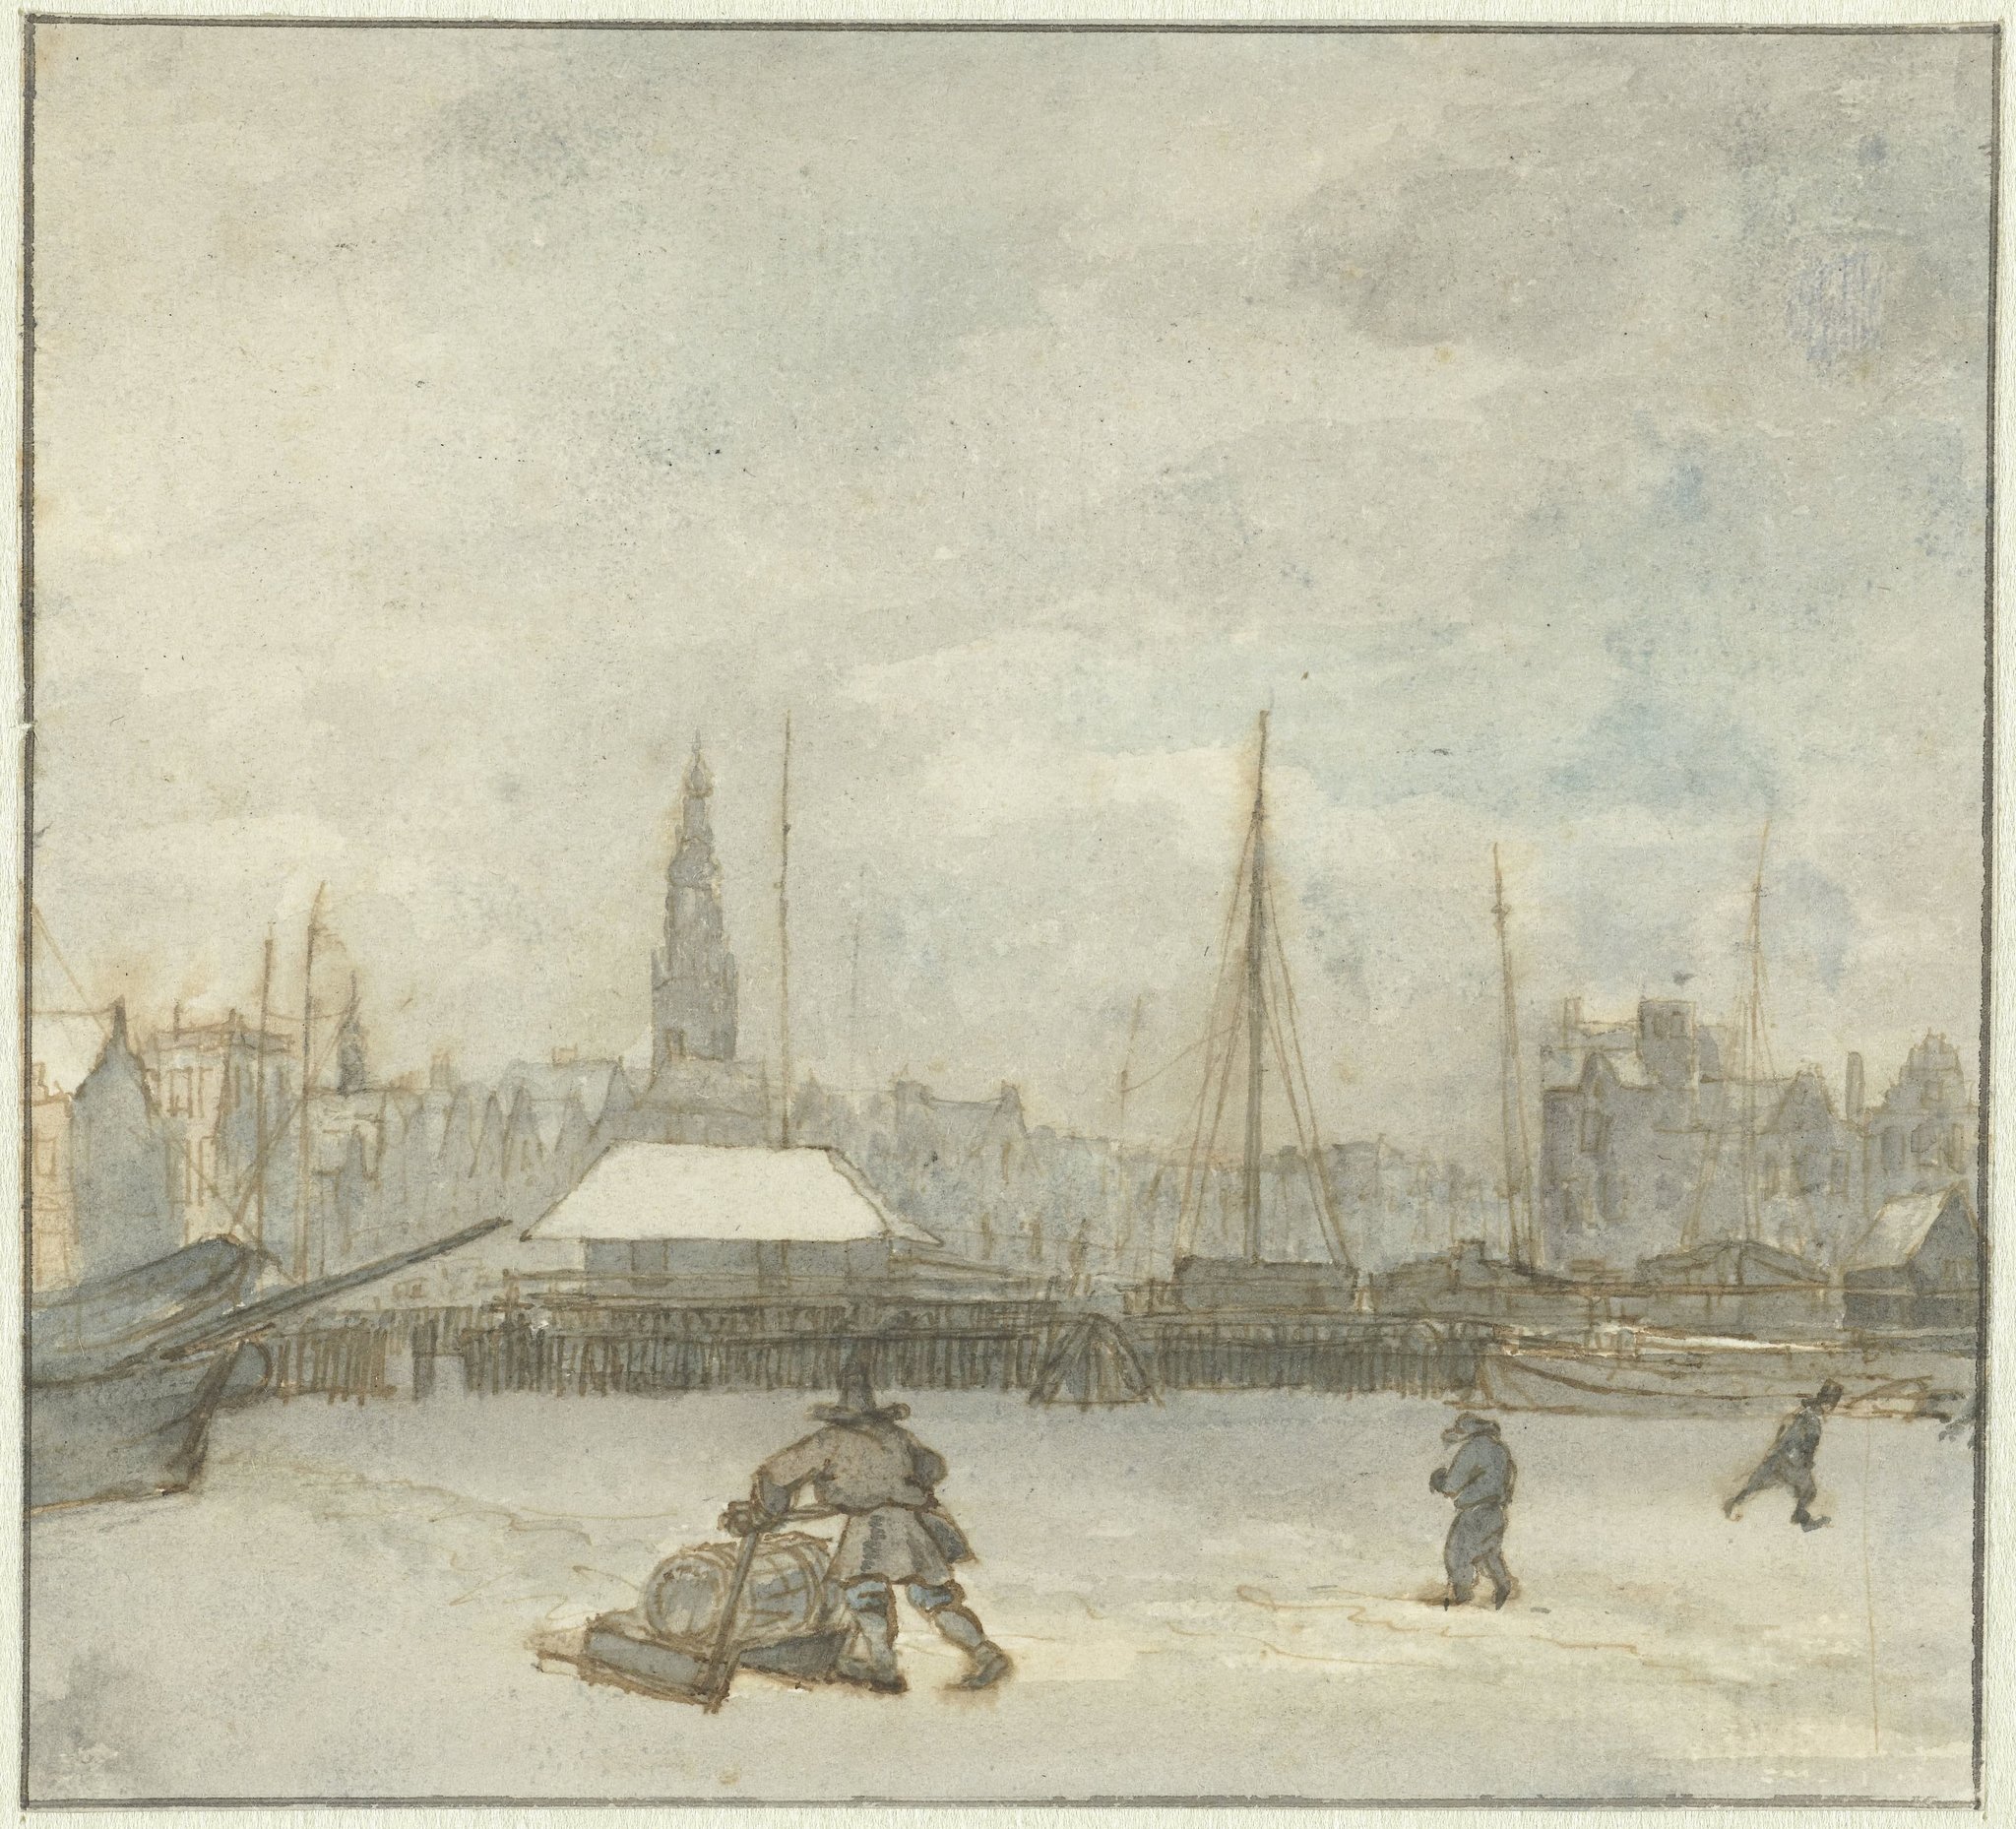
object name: drawing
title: Wintergezicht te Amsterdam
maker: gerrit lamberts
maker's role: bookseller, draughtsman, print maker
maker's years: 1776-1850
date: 1786-1850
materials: ink, paper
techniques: brush, pen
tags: winter sports, ice ~ freezing weather, public road, amsterdam